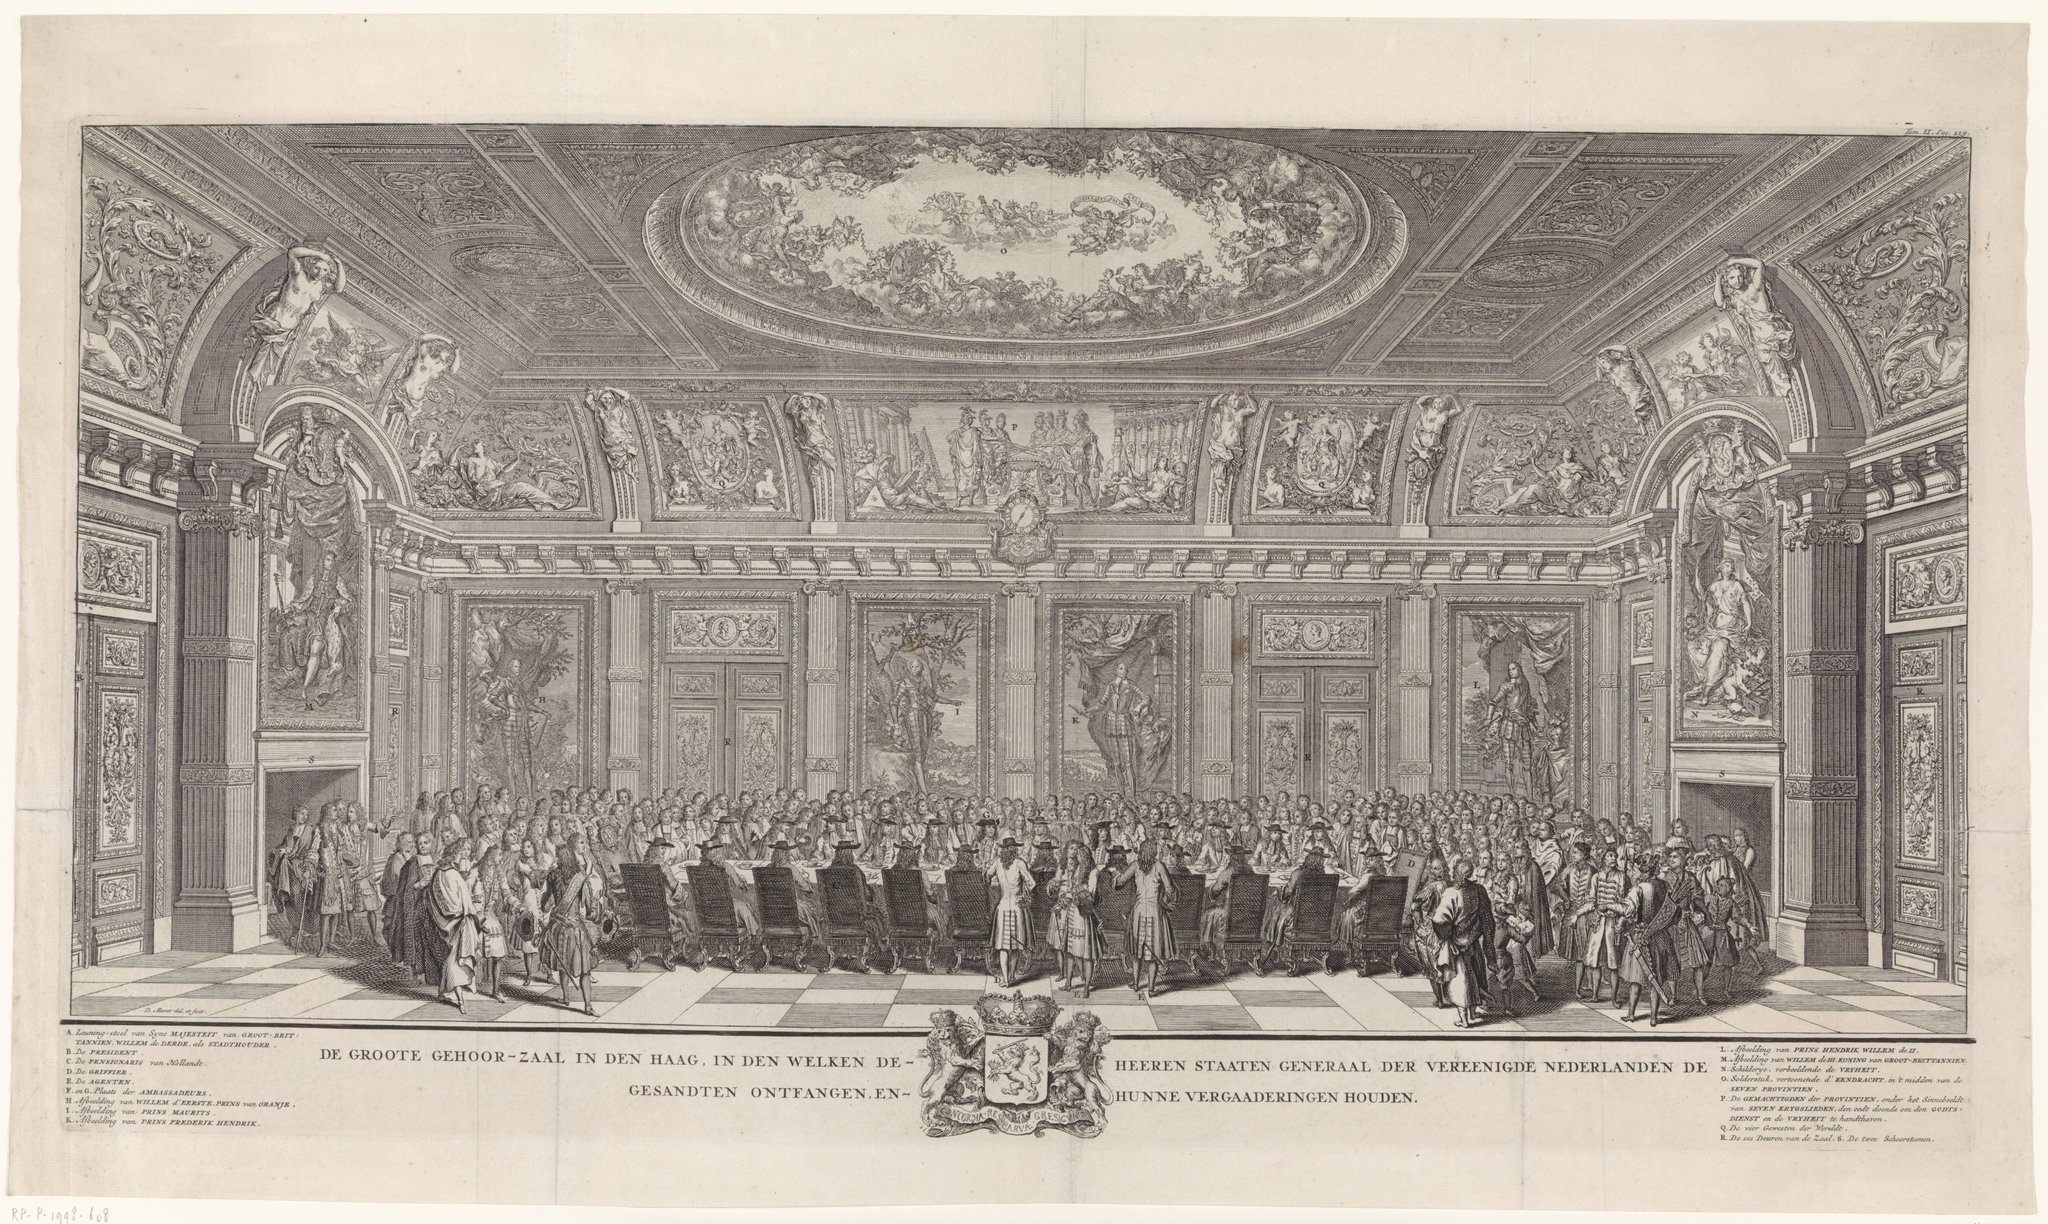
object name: book illustration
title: De opening van de nieuwe audiëntiezaal van de Staten-Generaal (Trêveszaal), 1697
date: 1730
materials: paper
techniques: engraving, etching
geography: the hague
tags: ceremony ~ putting a building into use, assembly-room, coat of arms (as symbol of the state, etc.) (+ nation; national), reception ~ ambassador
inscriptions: collector's mark: Lugt 2228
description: De Trêveszaal, de nieuwe audiëntiezaal waar de Staten-Generaal buitenlandse ambassadeurs ontvangt, in gebruik genomen in oktober 1697. De zaal is vol met leden van de Staten-Generaal en verschillende buitenlandse gezanten. Aan de wanden schilderijen met portretten van stadhouders en allegorische voorstellingen. Onderaan een legenda A-S, de titel en in het midden het wapen van de Staten-Generaal. Rechtsboven gemerkt: Tom. II. Pag: 129.